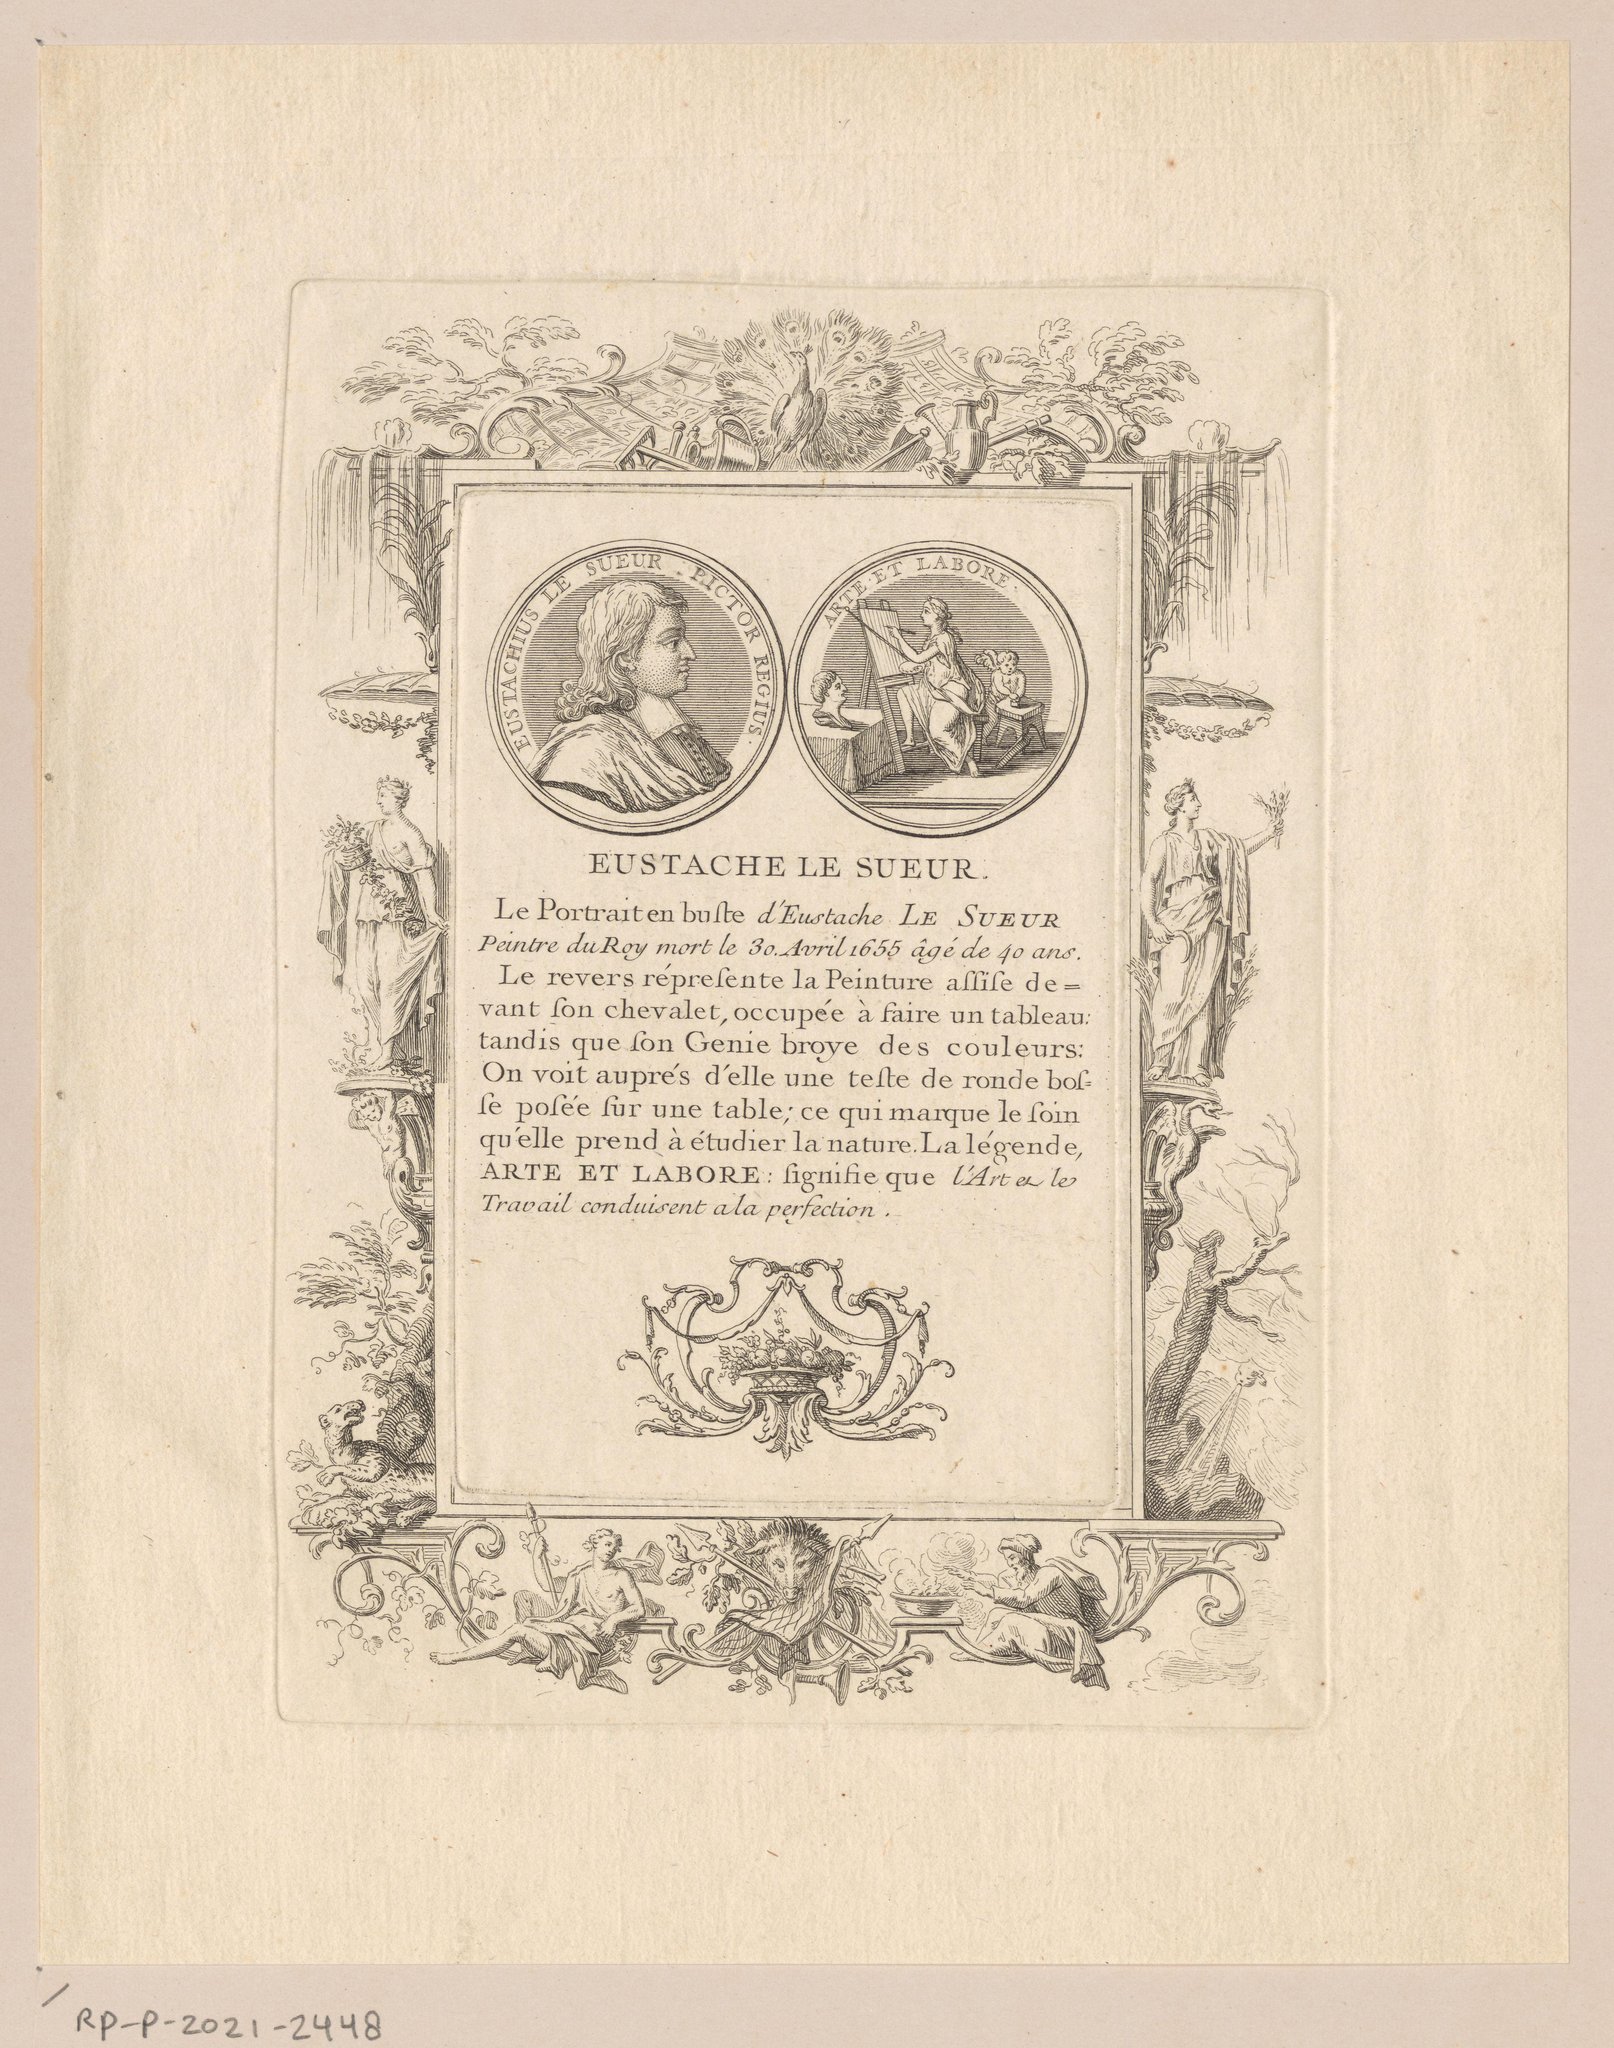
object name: print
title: Voor- en achterzijde van een penning met het portret van Eustache Lesueur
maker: Anonymous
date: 1700-1799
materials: paper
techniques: etching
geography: france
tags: paris, painter, draughtsman, eustache lesueur, historical persons, ornamental birds: peacock, portrait, self-portrait of painter, coin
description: Met beschrijving van de munt in het Frans.